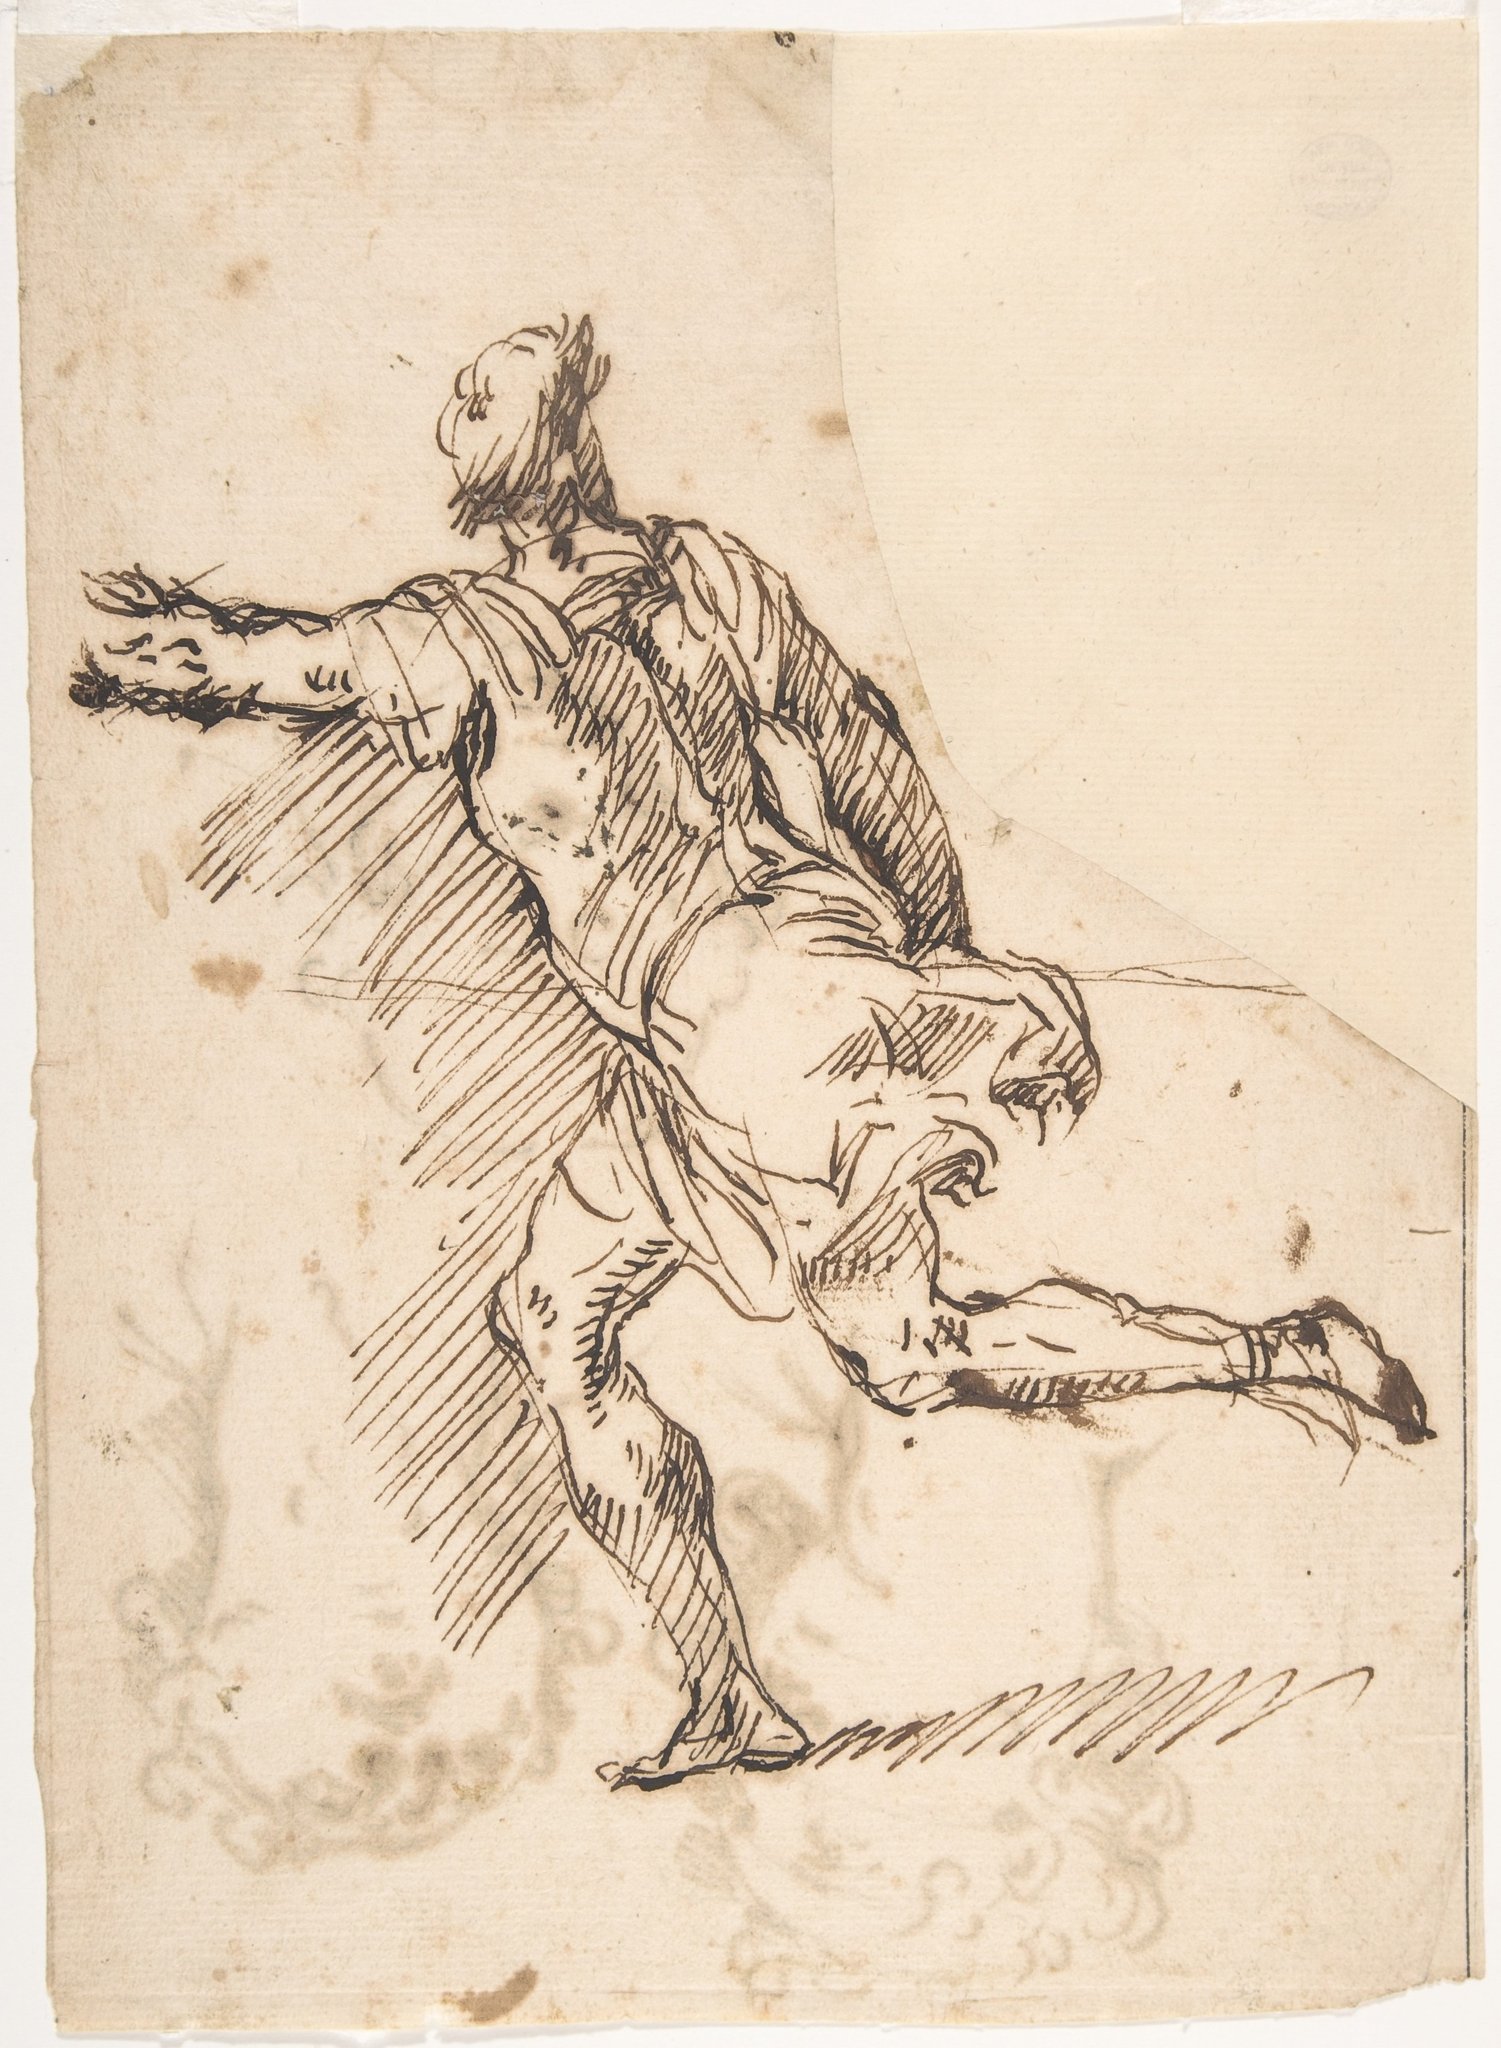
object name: drawing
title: Male Figure Running (recto); Three Pen Studies of Male Heads (verso)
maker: micco spadaro (domenico gargiulo)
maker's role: artist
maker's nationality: italian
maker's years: 1609-1675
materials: ink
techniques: pen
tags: heads,men,running